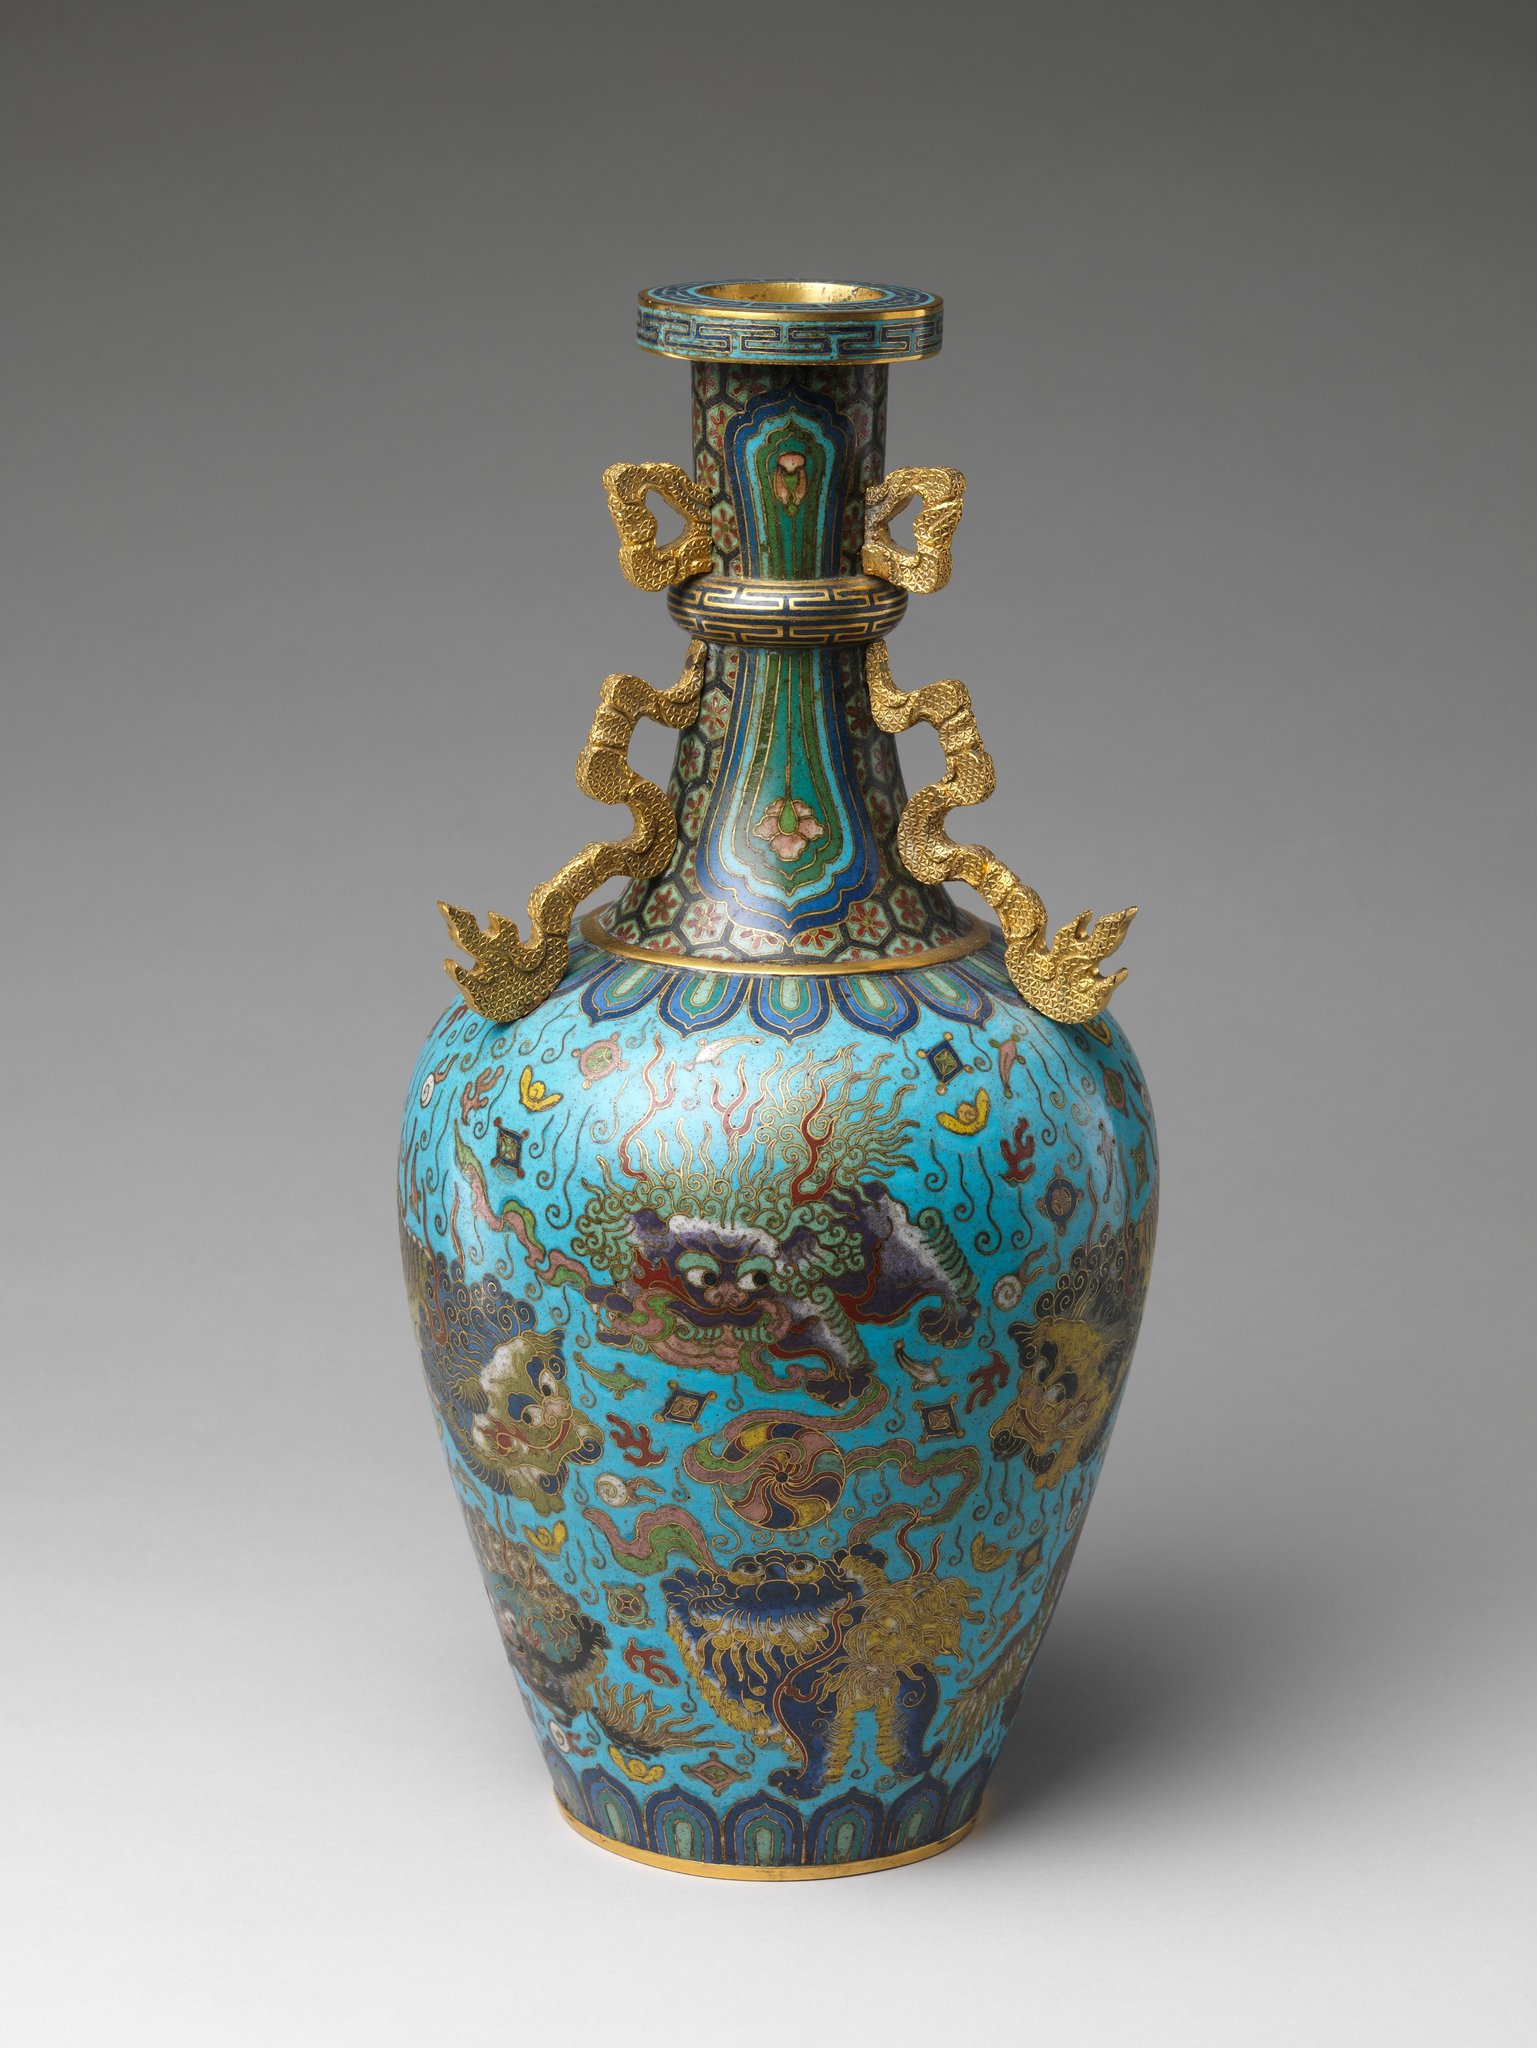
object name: vase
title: Vase with lions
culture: chinese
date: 1736-1795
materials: enamel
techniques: enamel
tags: mythical creatures